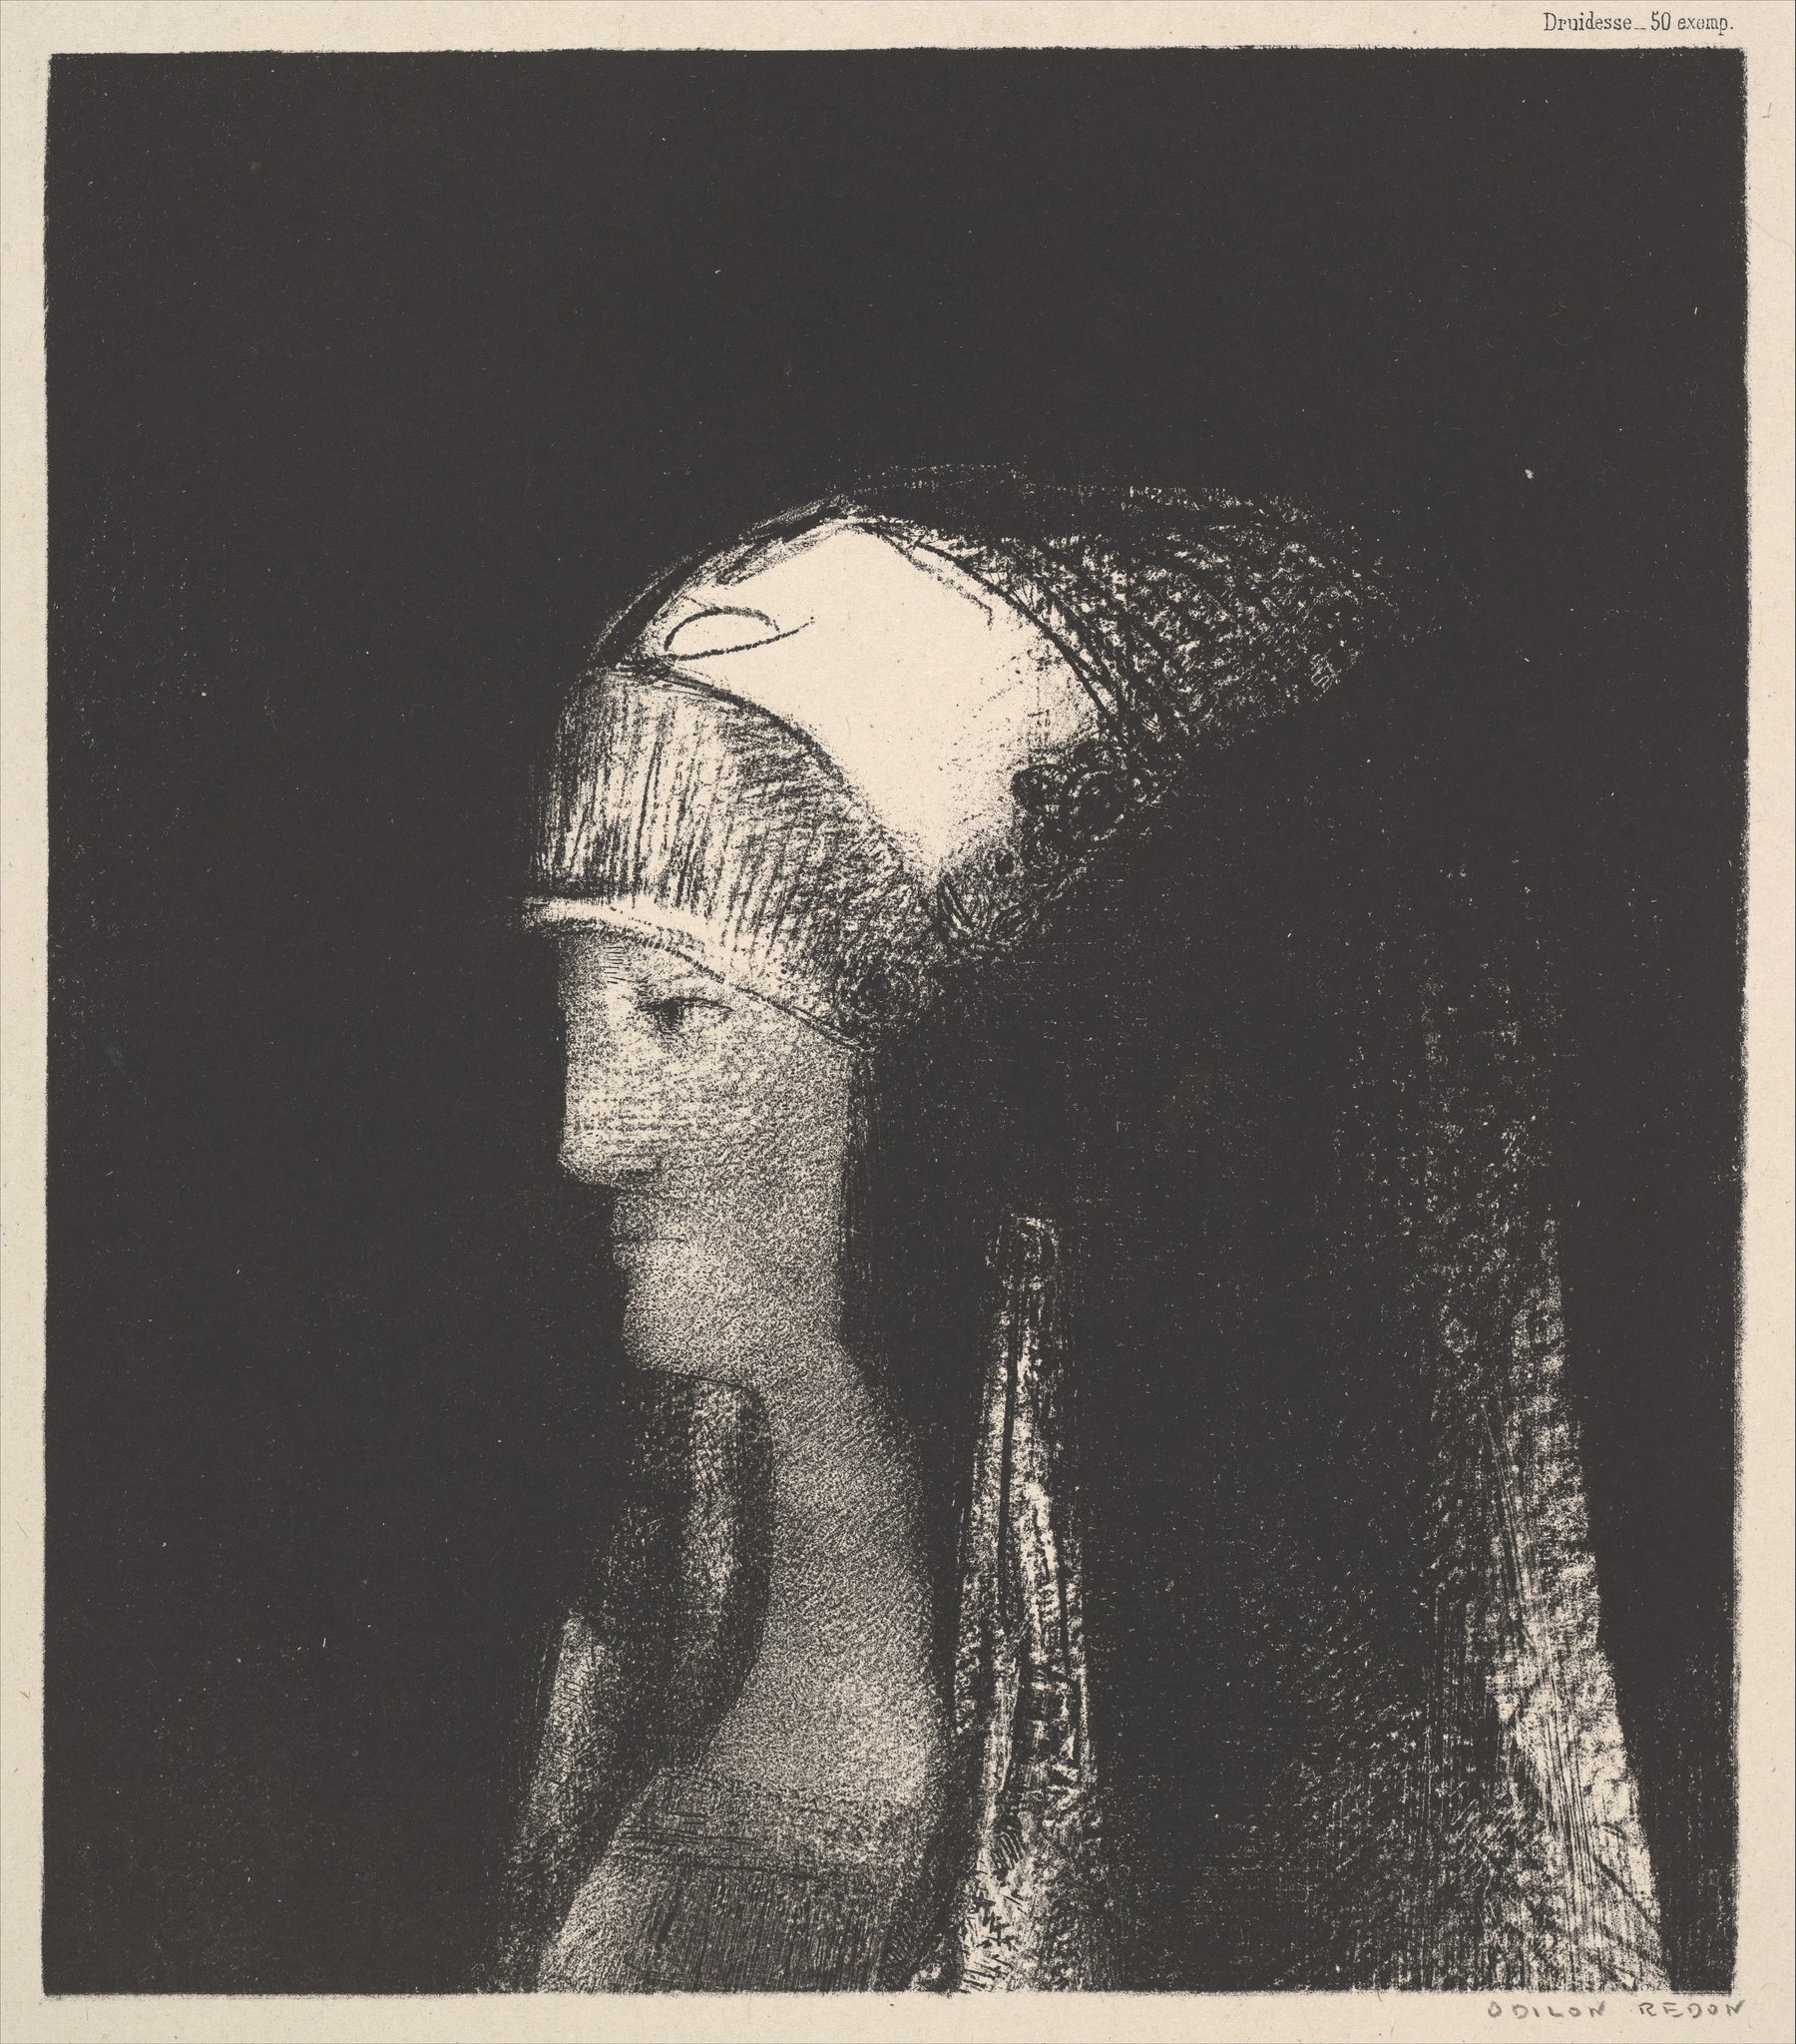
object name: print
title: Druidesse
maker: odilon redon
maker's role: artist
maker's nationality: french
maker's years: 1840-1916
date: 1891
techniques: lithography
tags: profiles,women